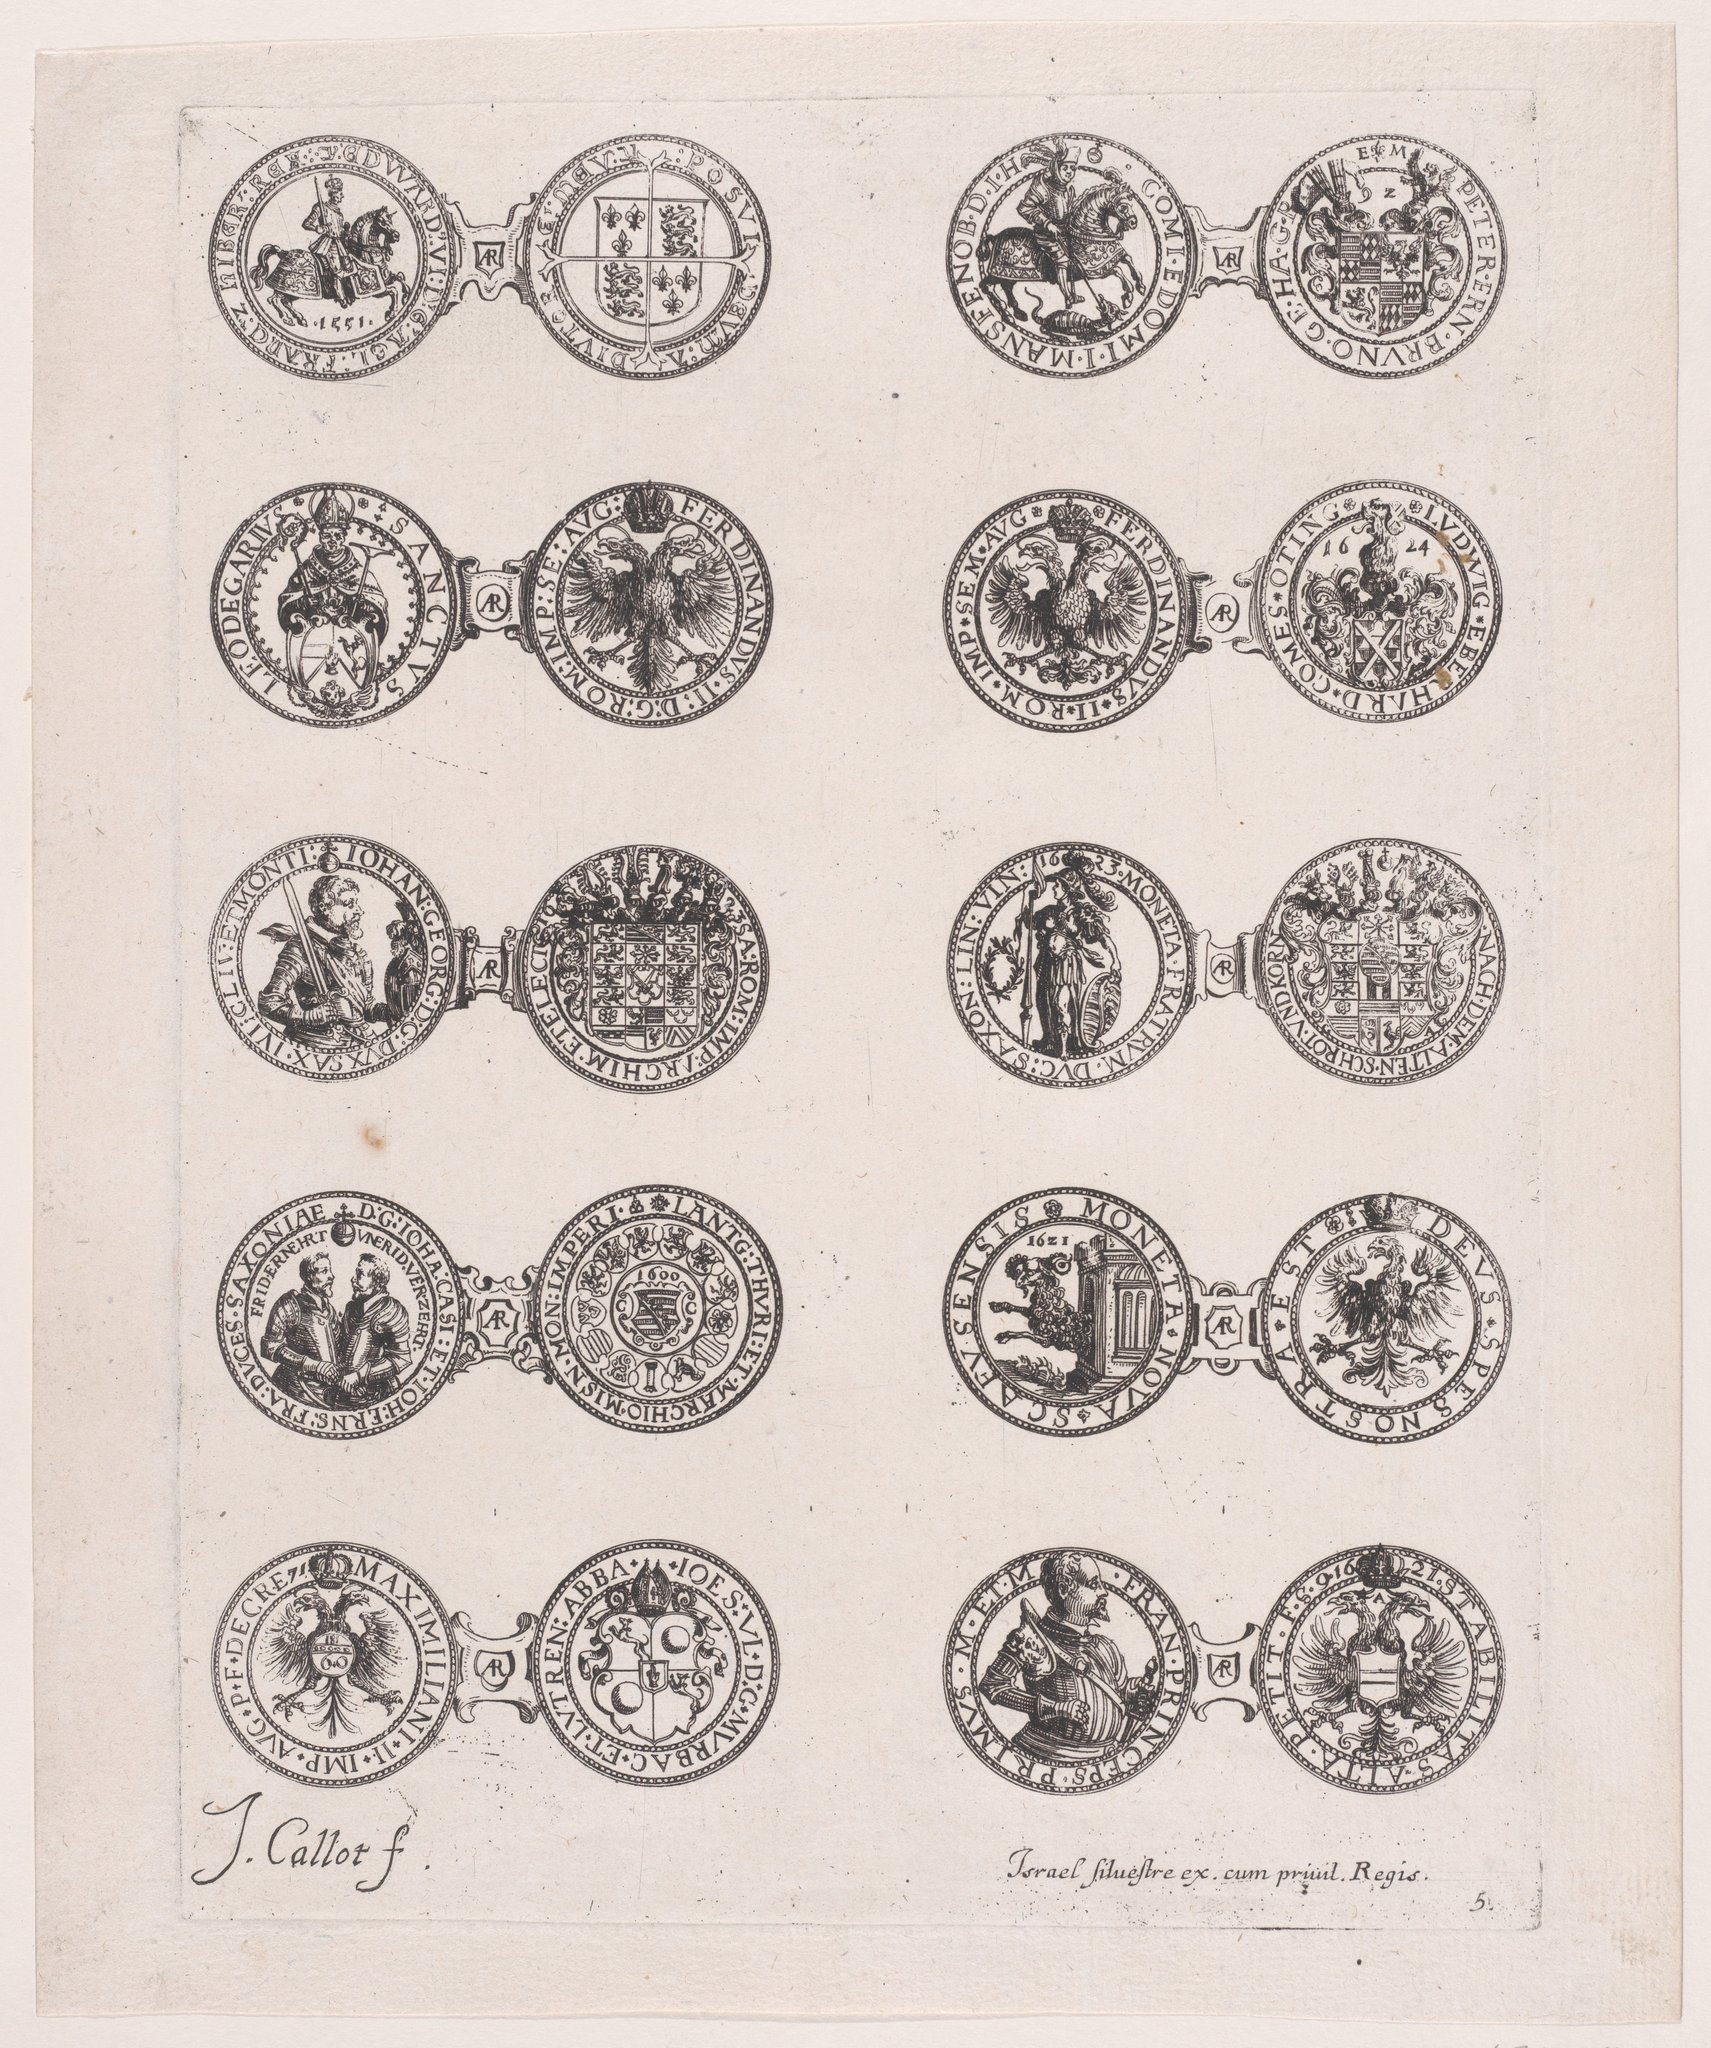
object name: print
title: Plate 5, Featuring 10 Coins Issued by European Princes in the 16th and 17th centuries, from "Les Monnaies" (The Currencies)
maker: jacques callot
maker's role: artist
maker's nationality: french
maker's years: 1592-1635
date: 1630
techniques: etching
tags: coins